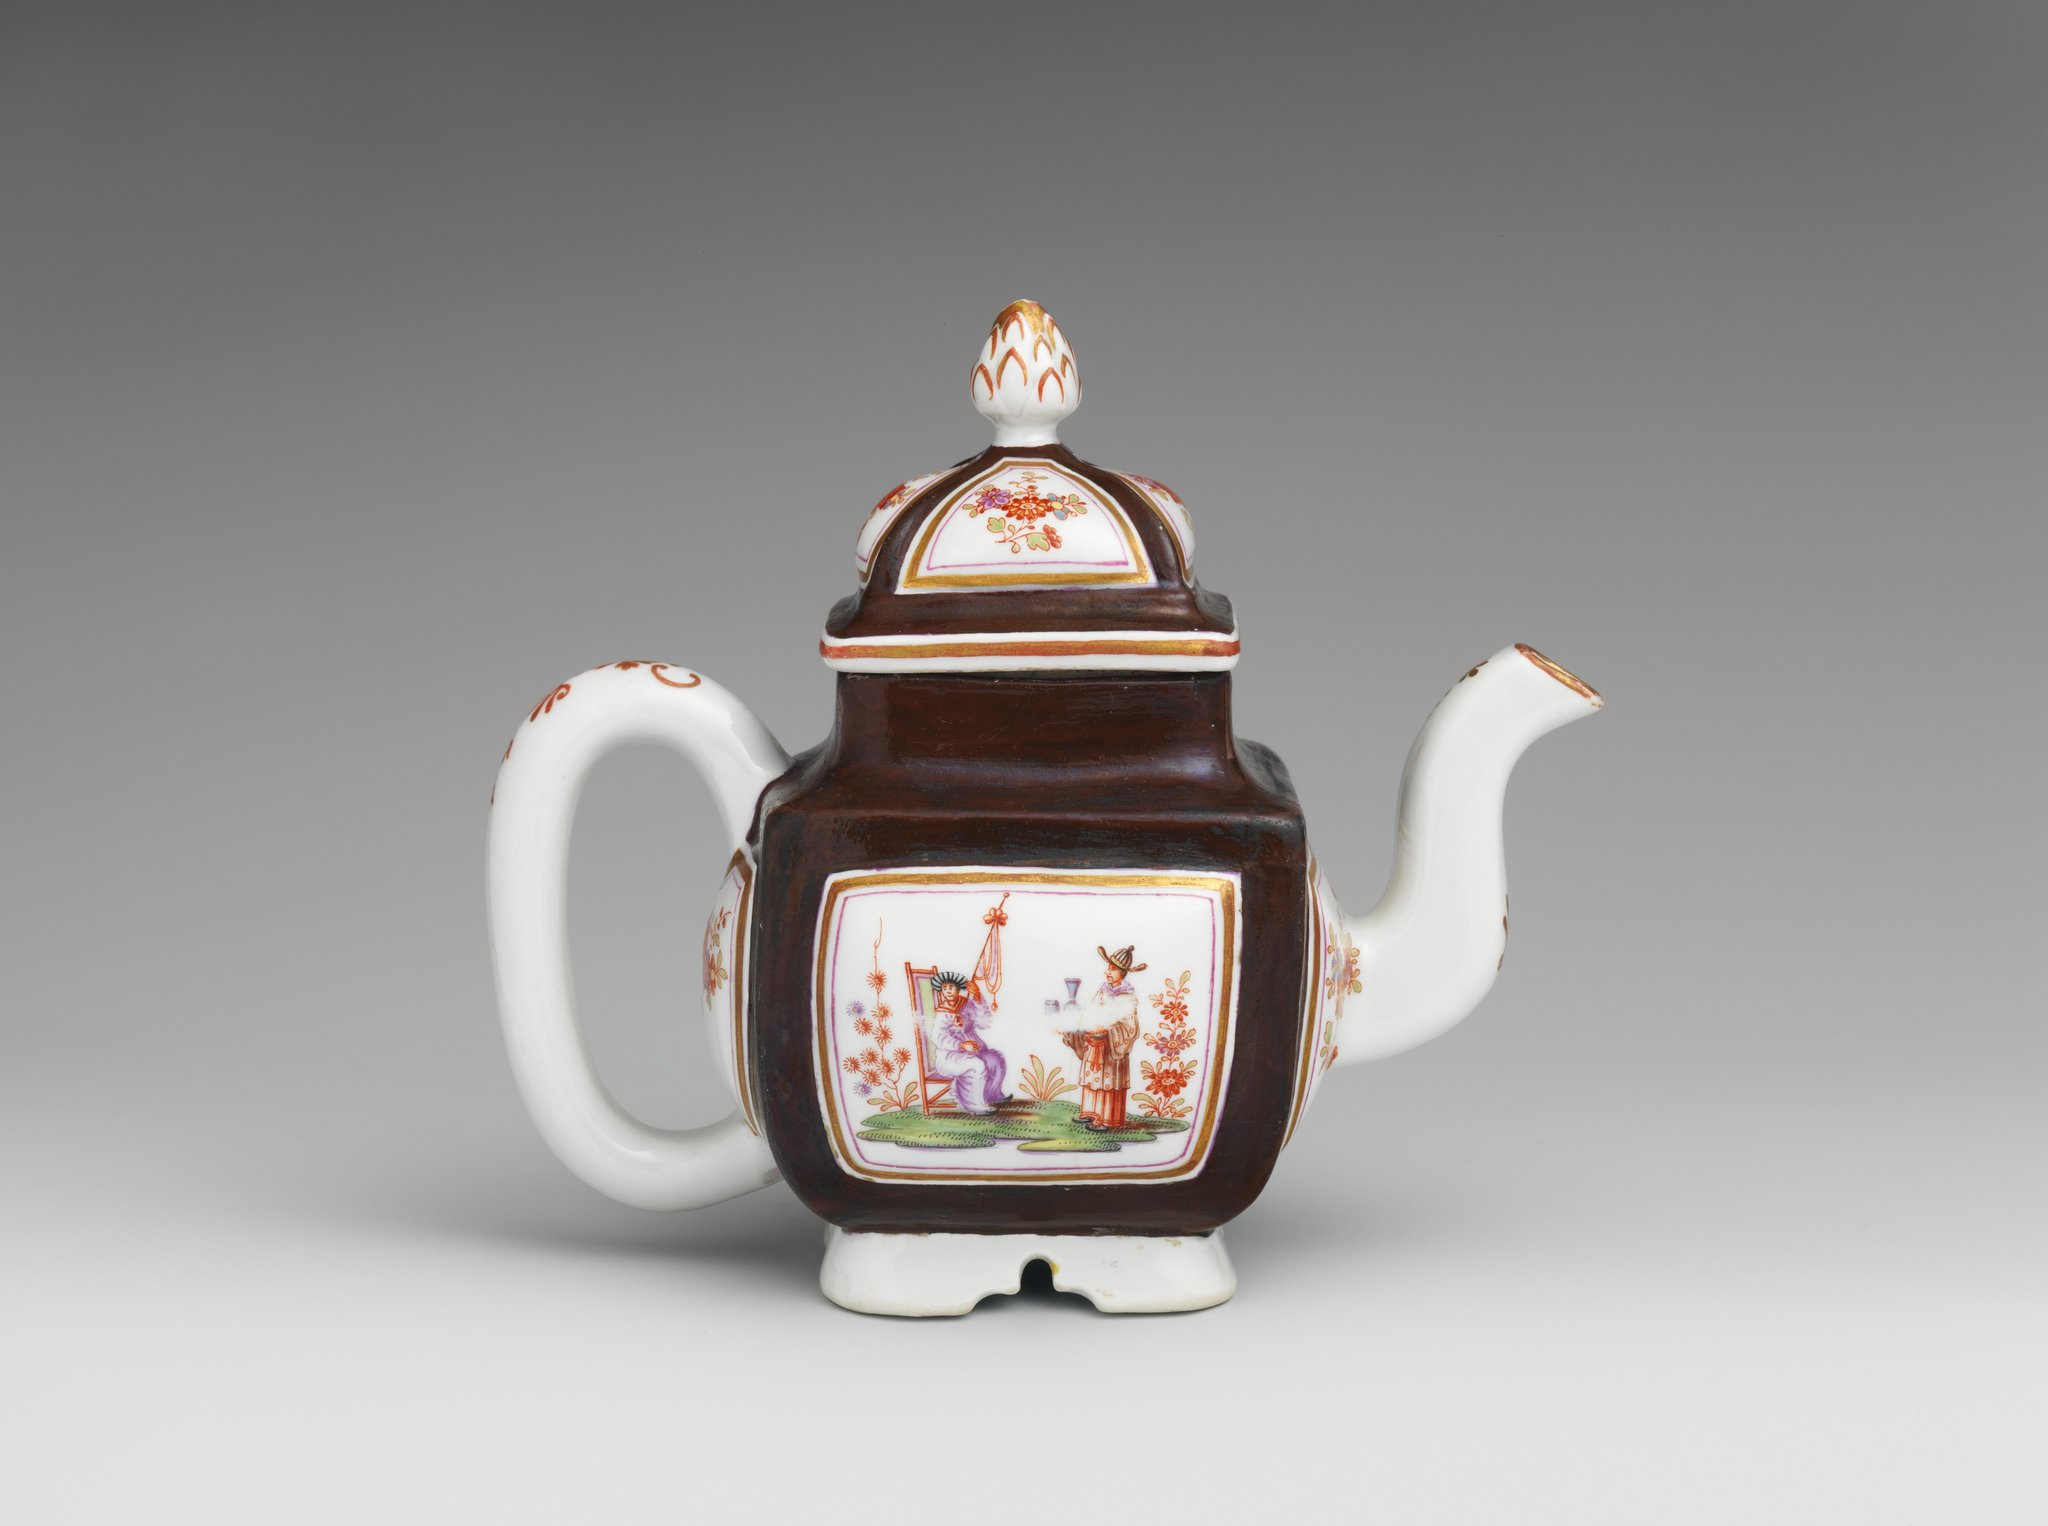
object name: teapot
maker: vienna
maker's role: manufactory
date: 1730-1735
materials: hard paste porcelain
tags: chinoiserie,men,flowers